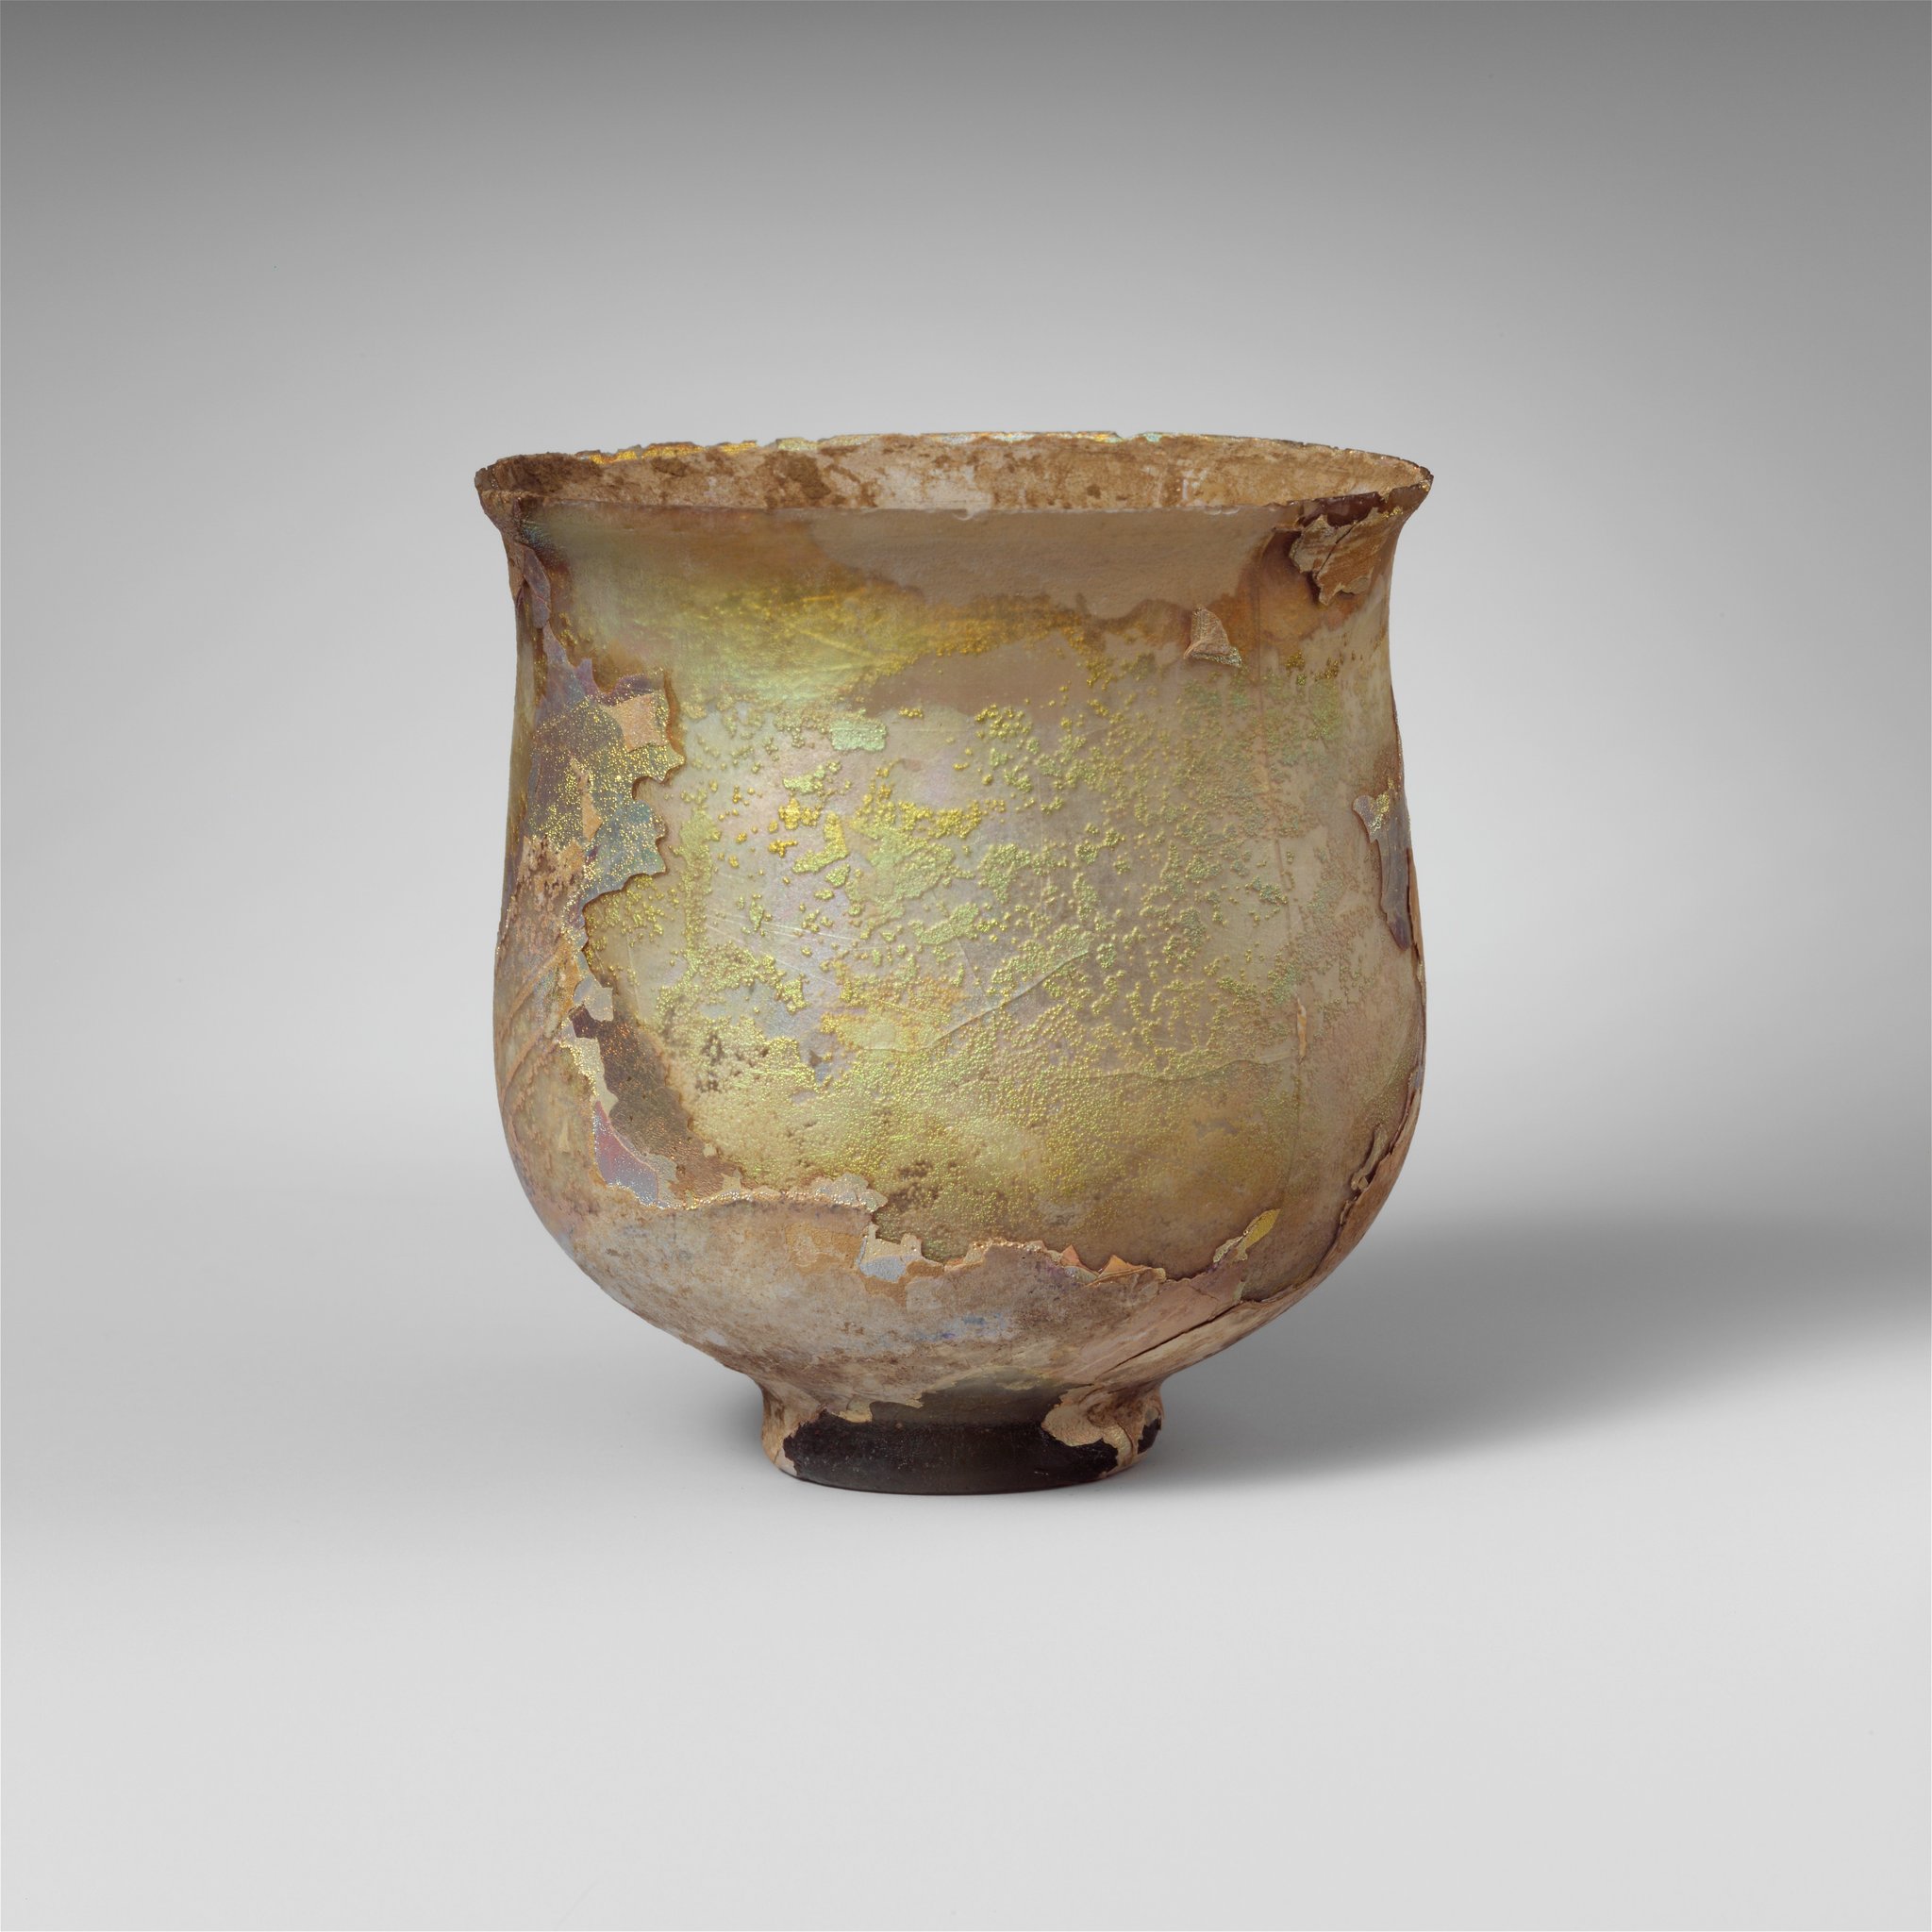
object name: beaker or cup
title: Glass beaker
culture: roman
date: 201-300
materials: glass